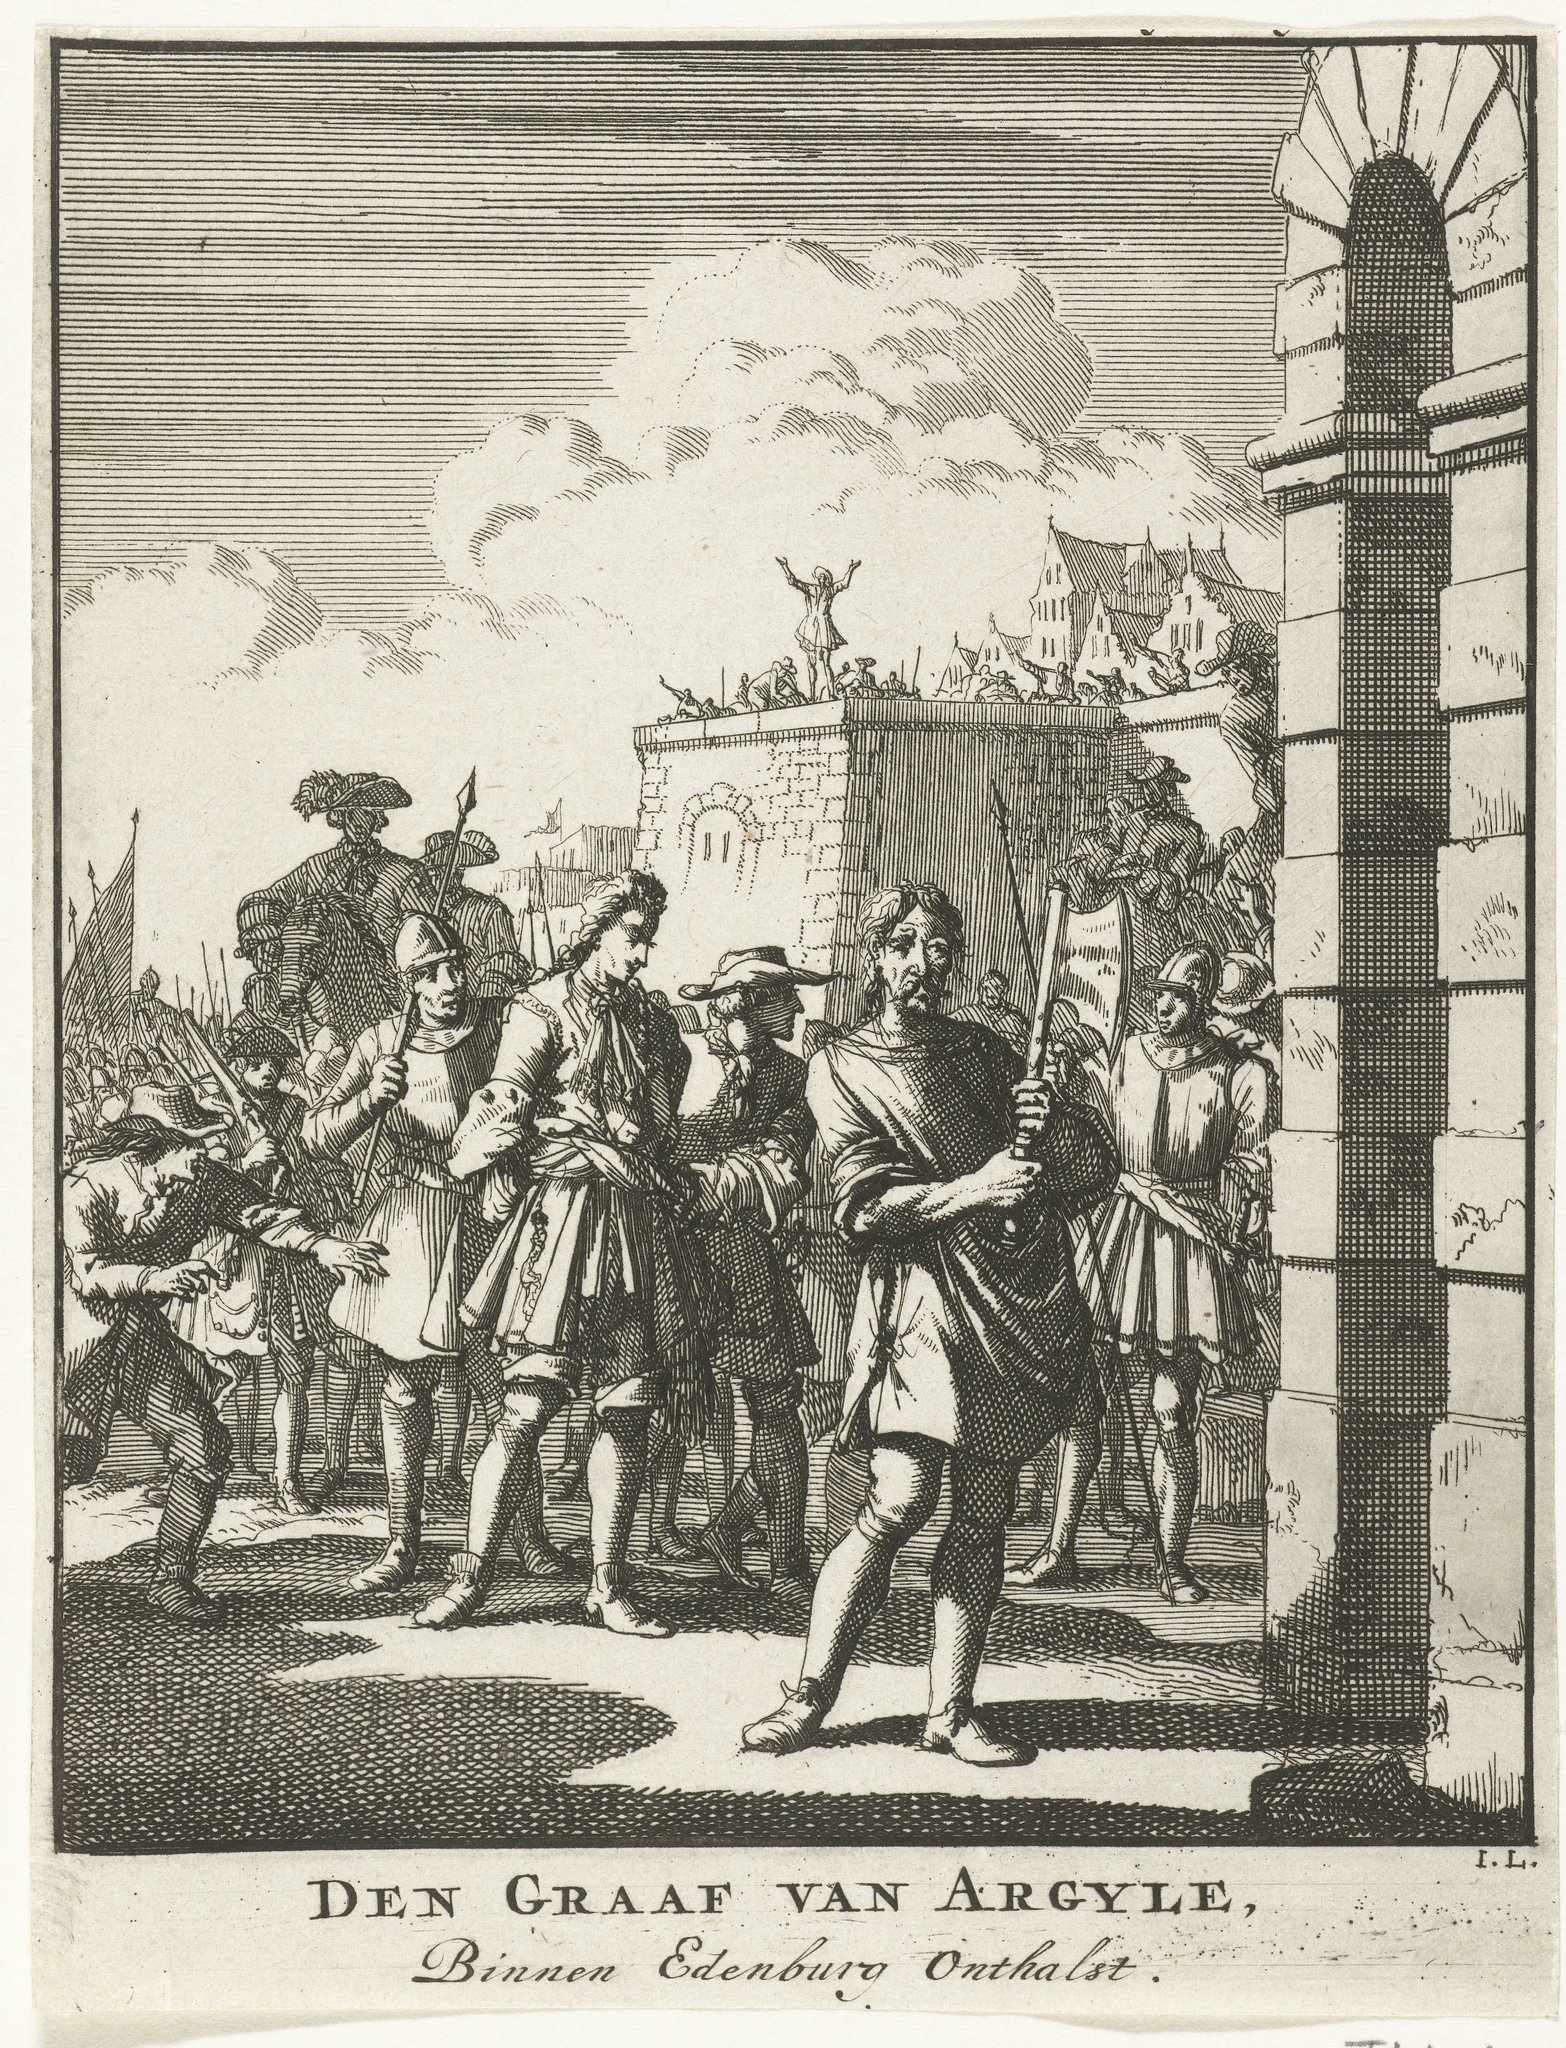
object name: print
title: Den Graaf van Argyle, Binnen Edenburg Onthalst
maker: jan luyken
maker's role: draughtsman, print maker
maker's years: 1649-1712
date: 1689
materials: paper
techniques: etching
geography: northern netherlands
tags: earl, (person under sentence of death) on the way to the scaffold or place of execution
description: Voorbereiding voor de onthoofding van Archibald Campbell, tweede markies en negende graaf van Argyll te Edinburgh op 30 juni 1685. De graaf van Argyll leidde samen de hertog van Monmouth een opstand tegen de katholieke koning Jacobus.